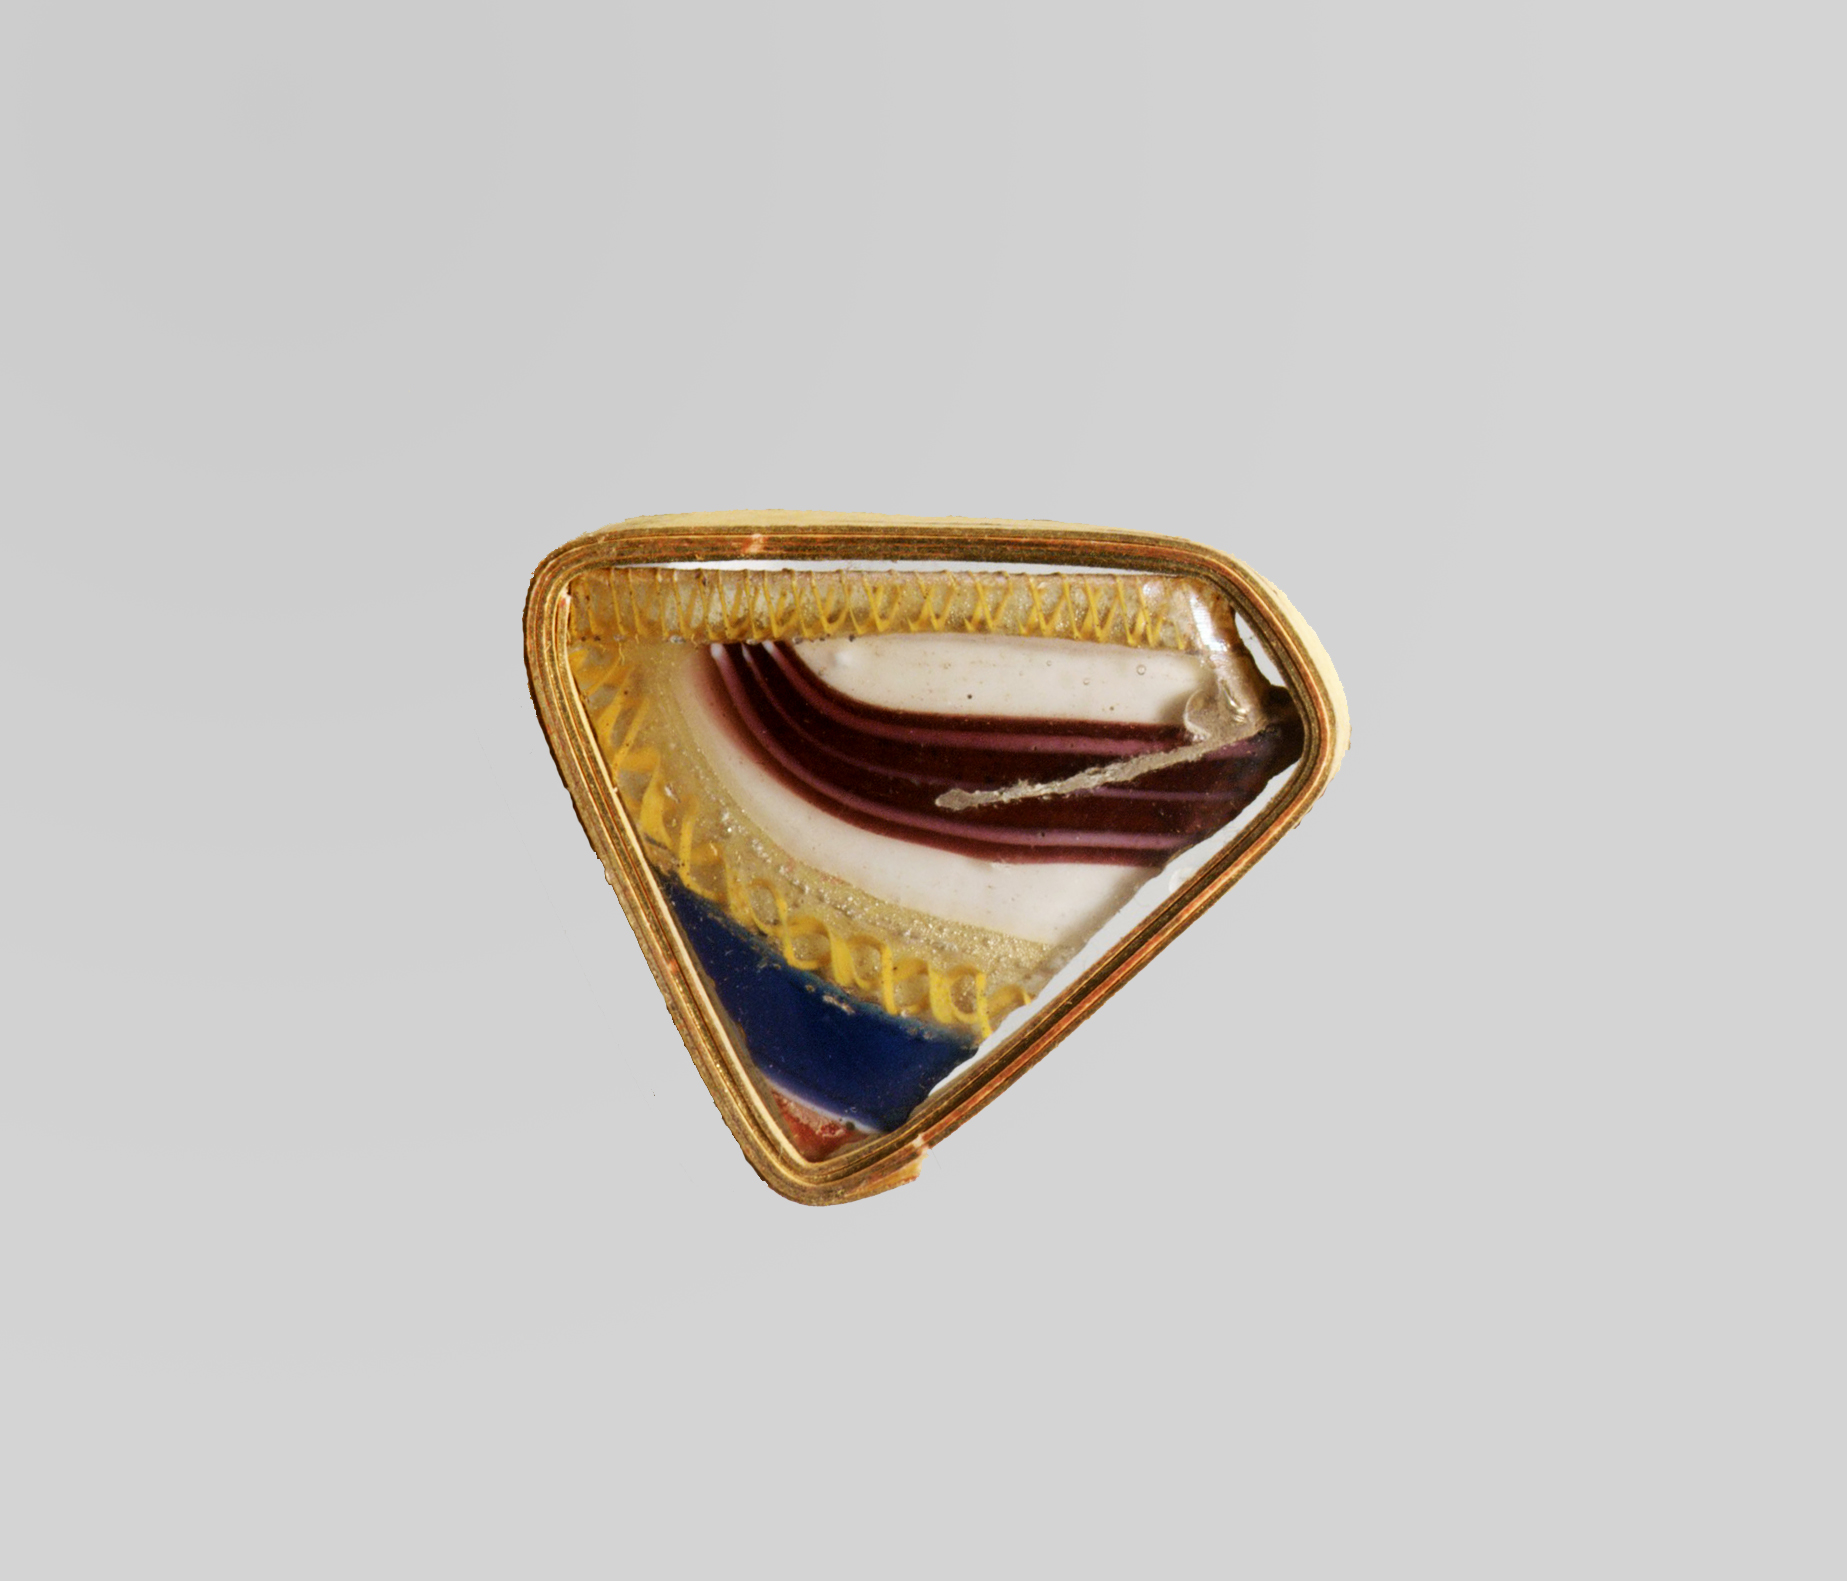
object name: fragment, striped mosaic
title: Glass striped mosaic bowl fragment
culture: roman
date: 34 BCE-33 CE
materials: glass